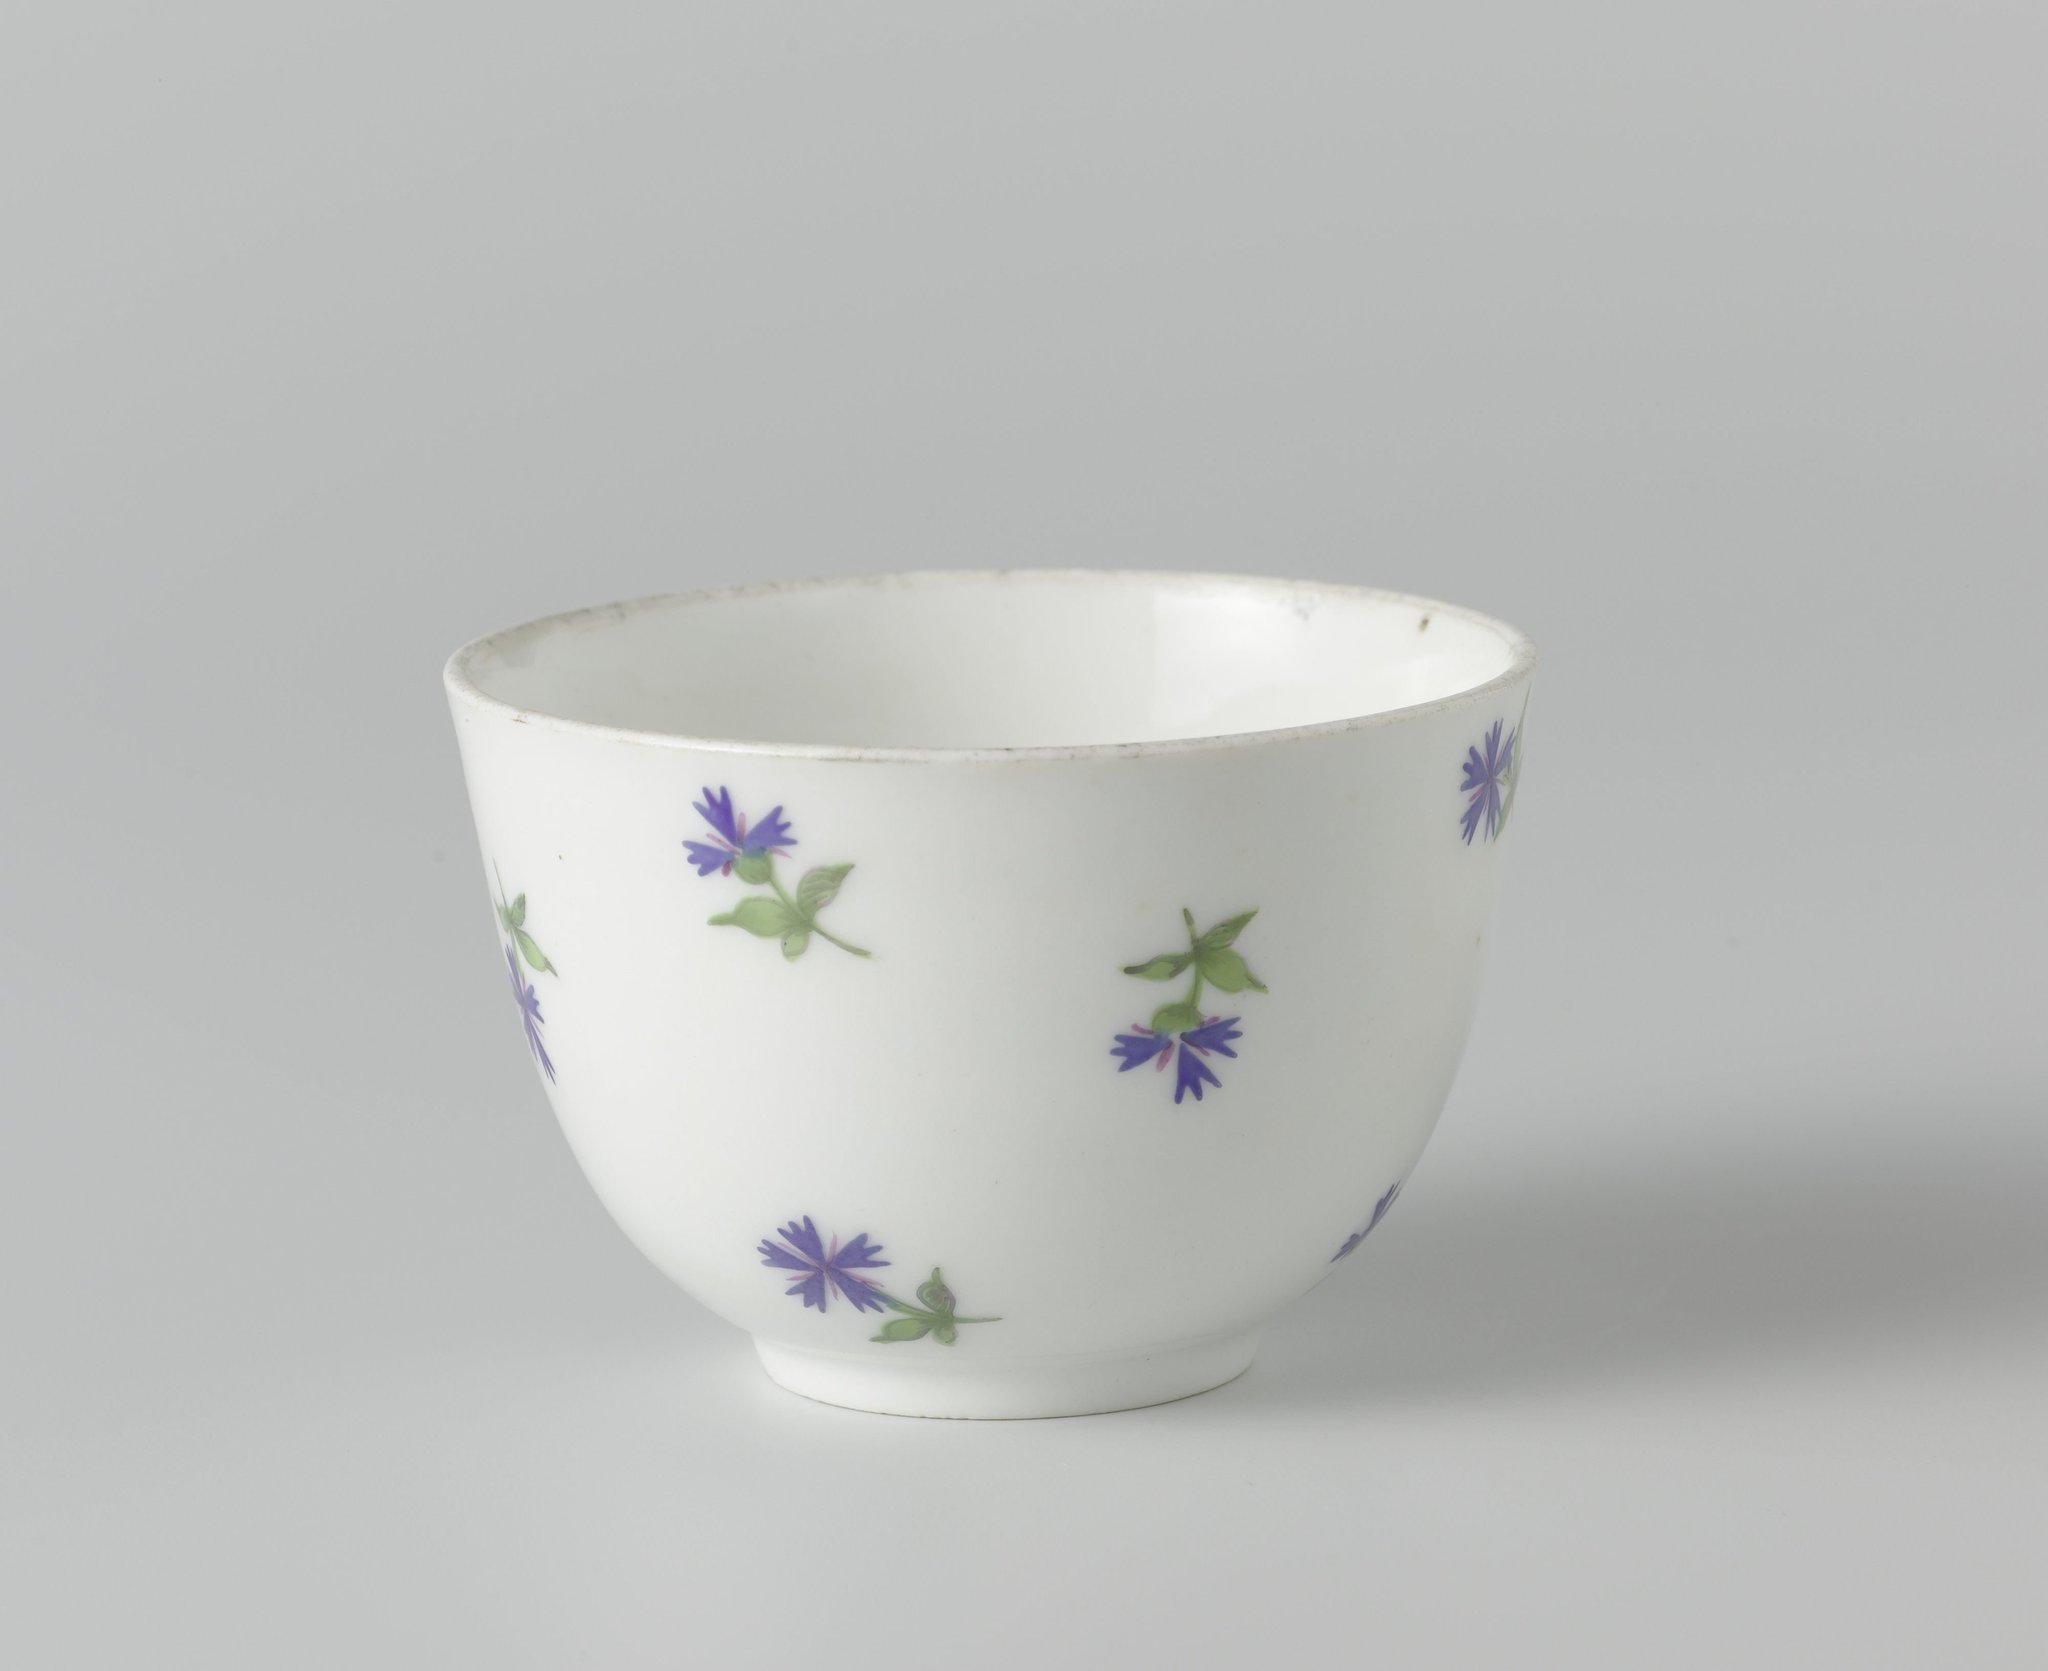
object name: cup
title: Kop, beschilderd met korenbloemen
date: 1784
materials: porcelain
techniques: painted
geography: loosdrecht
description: Kop, versierd met korenbloemen. Gemerkt Amstel in blauw onder het glazuur en ingegrift L48